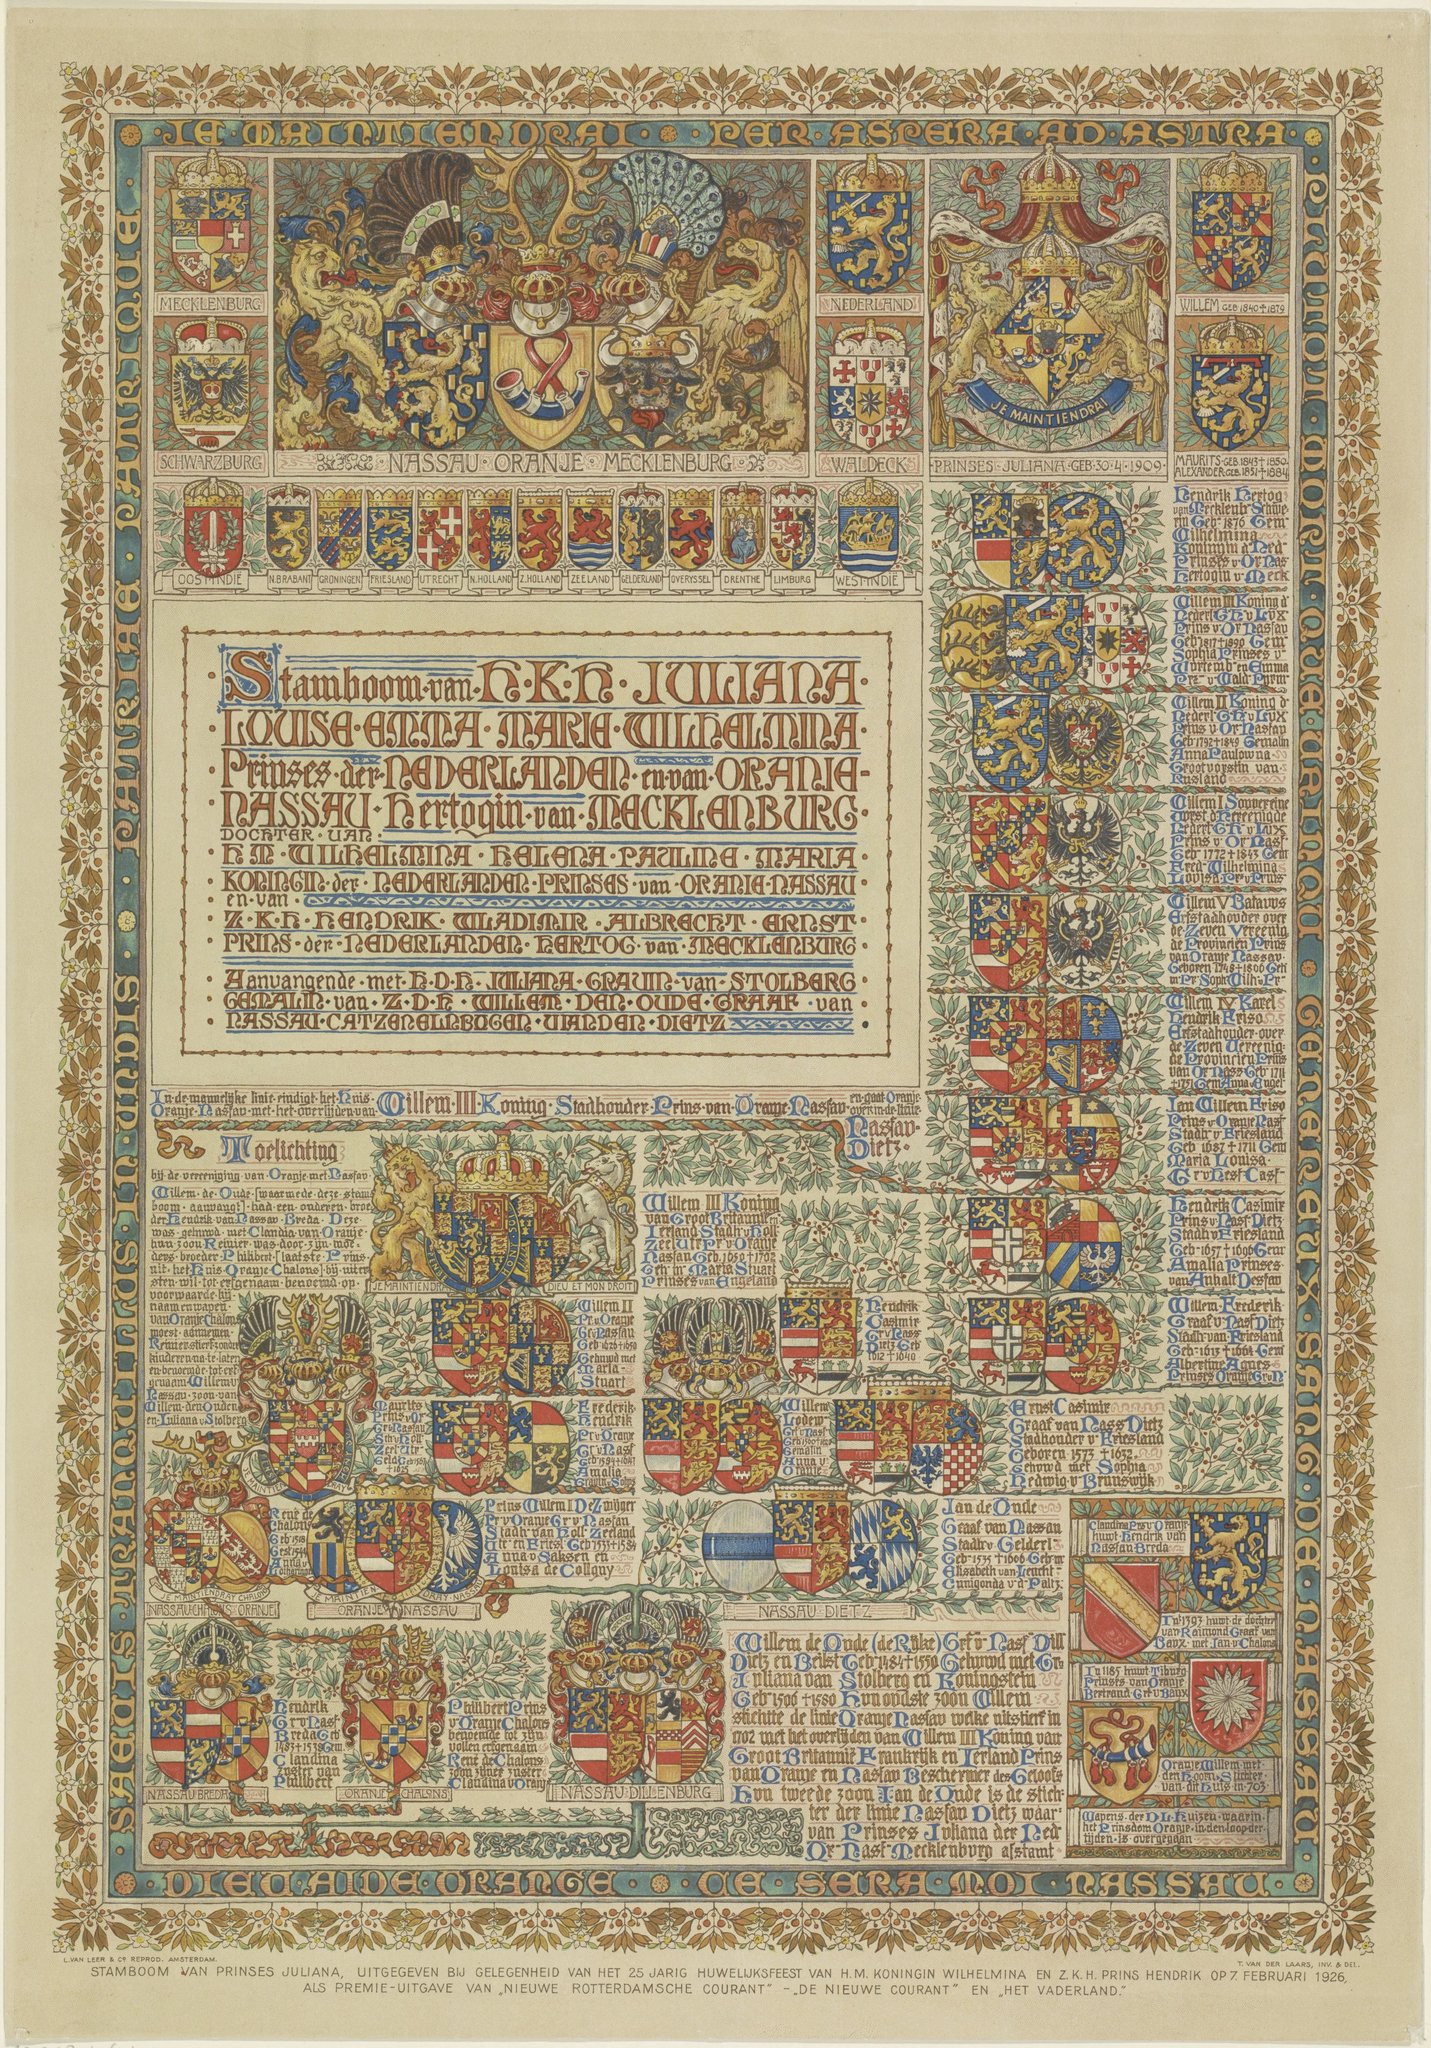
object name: print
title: Stamboom van Juliana, koningin der Nederlanden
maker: tiete van der laars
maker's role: designer, draughtsman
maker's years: 1861-1939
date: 1926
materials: paper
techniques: lithograph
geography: netherlands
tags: anna paulowna romanowa, print maker, wilhelmina of the netherlands, hendrik (prins der nederlanden (1876-1934)), emma (queen consort of the netherlands), william v (prince of orange), johan willem friso (prins van oranje-nassau), louise de coligny, william i of the netherlands, brussels, willem iii (koning der nederlanden), william iii (prince of orange and king of england, scotland, and ireland), paris, willem (prins der nederlanden), the hague, william ii of the netherlands, frederick henry (prince of orange), william ii (prince of orange), delft, william i (prince of orange), maurice (prince of orange), maria ii stuart (koningin van engeland, schotland en ierland), amalia of solms-braunfels, london, mary henrietta stuart, juliana of the netherlands, draughtsman, wilhelmina of prussia (princess of orange), sophia frederika mathilda van württemberg, willem iv (prins van oranje-nassau), anna van hannover, berlin, wilhelmina frederica louisa (koningin der nederlanden)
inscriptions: collector's mark: Lugt 2233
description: Stamboom van Juliana, van Willem I tot en met Juliana. In een geornamenteerde rechthoek dertien regels Nederlandse tekst. Daar omheen aan de takken van een boom meerdere wapens met namen en data. Geheel in een rechthoek van oranjetakken. Vervaardigd ter gelegenheid van het 25-jarig huwelijksjubileum van Wilhelmina en Hendrik in 1926. Premieplaat van de 'Nieuwe Rotterdamsche Courant', 'Het Vaderland' en de 'Nieuwe Courant'.